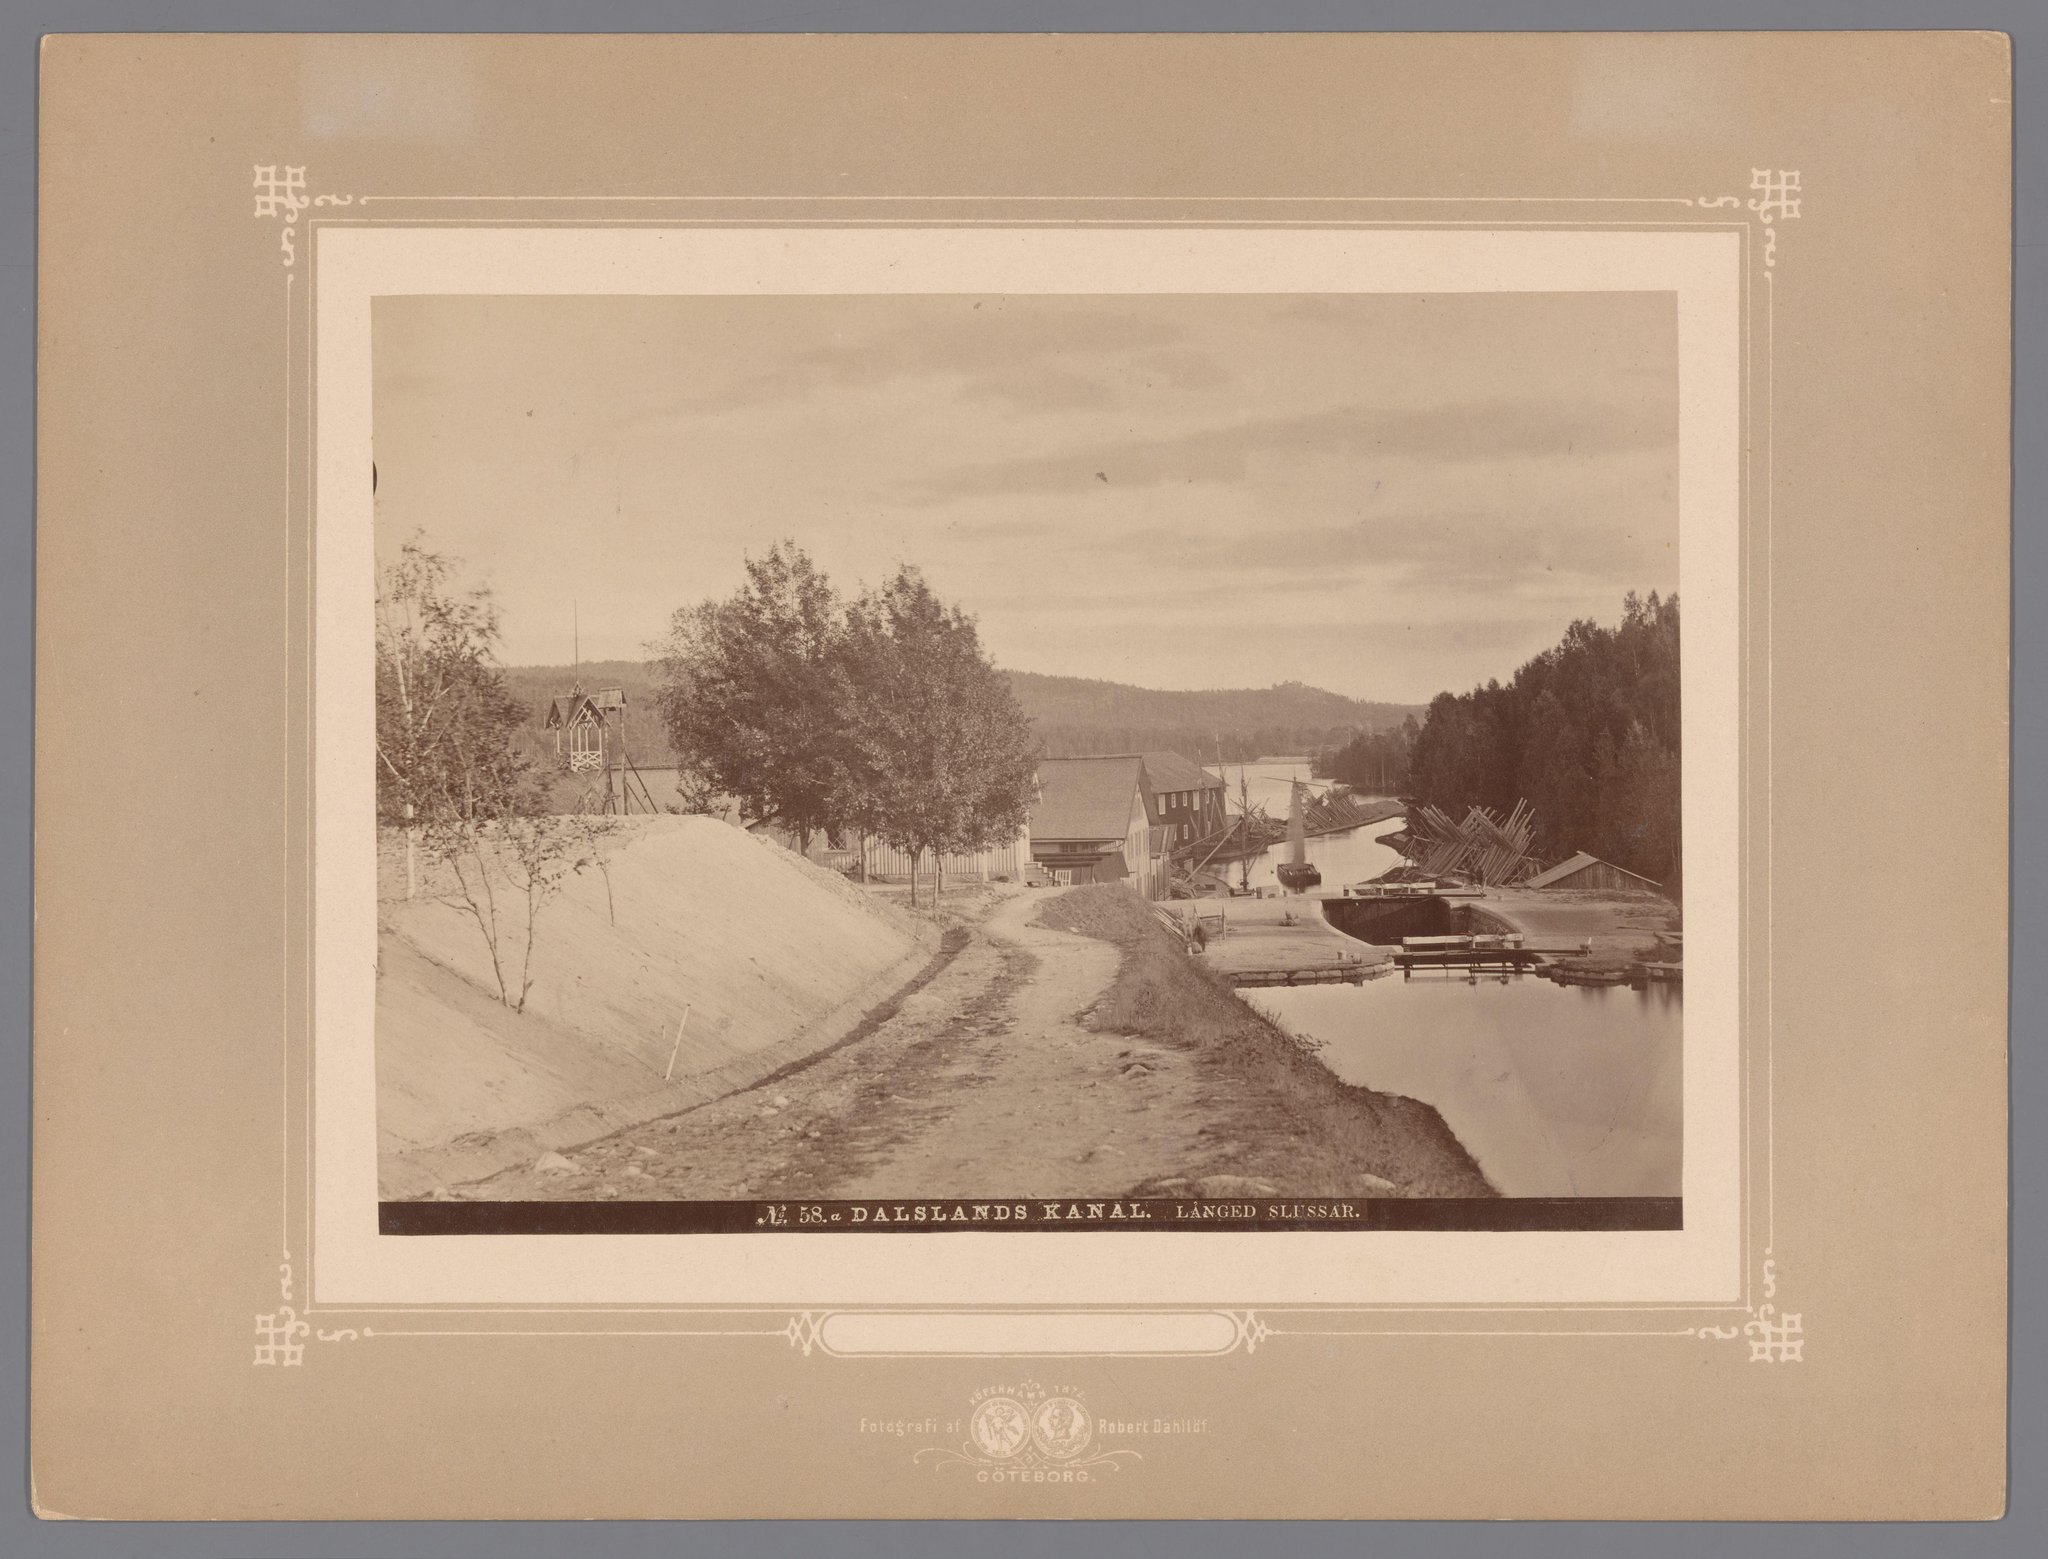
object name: photograph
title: Sluis in het Dalslandkanaal in Zweden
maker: robert dahllöf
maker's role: publisher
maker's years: 1842-1904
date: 1872-1874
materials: cardboard, paper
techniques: albumen print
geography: göteborg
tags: sluice, weir, canal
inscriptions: retailer's mark: ‘FR. HULDBERG/ Bazarin å Norrbro’, number: ‘No 58.a’